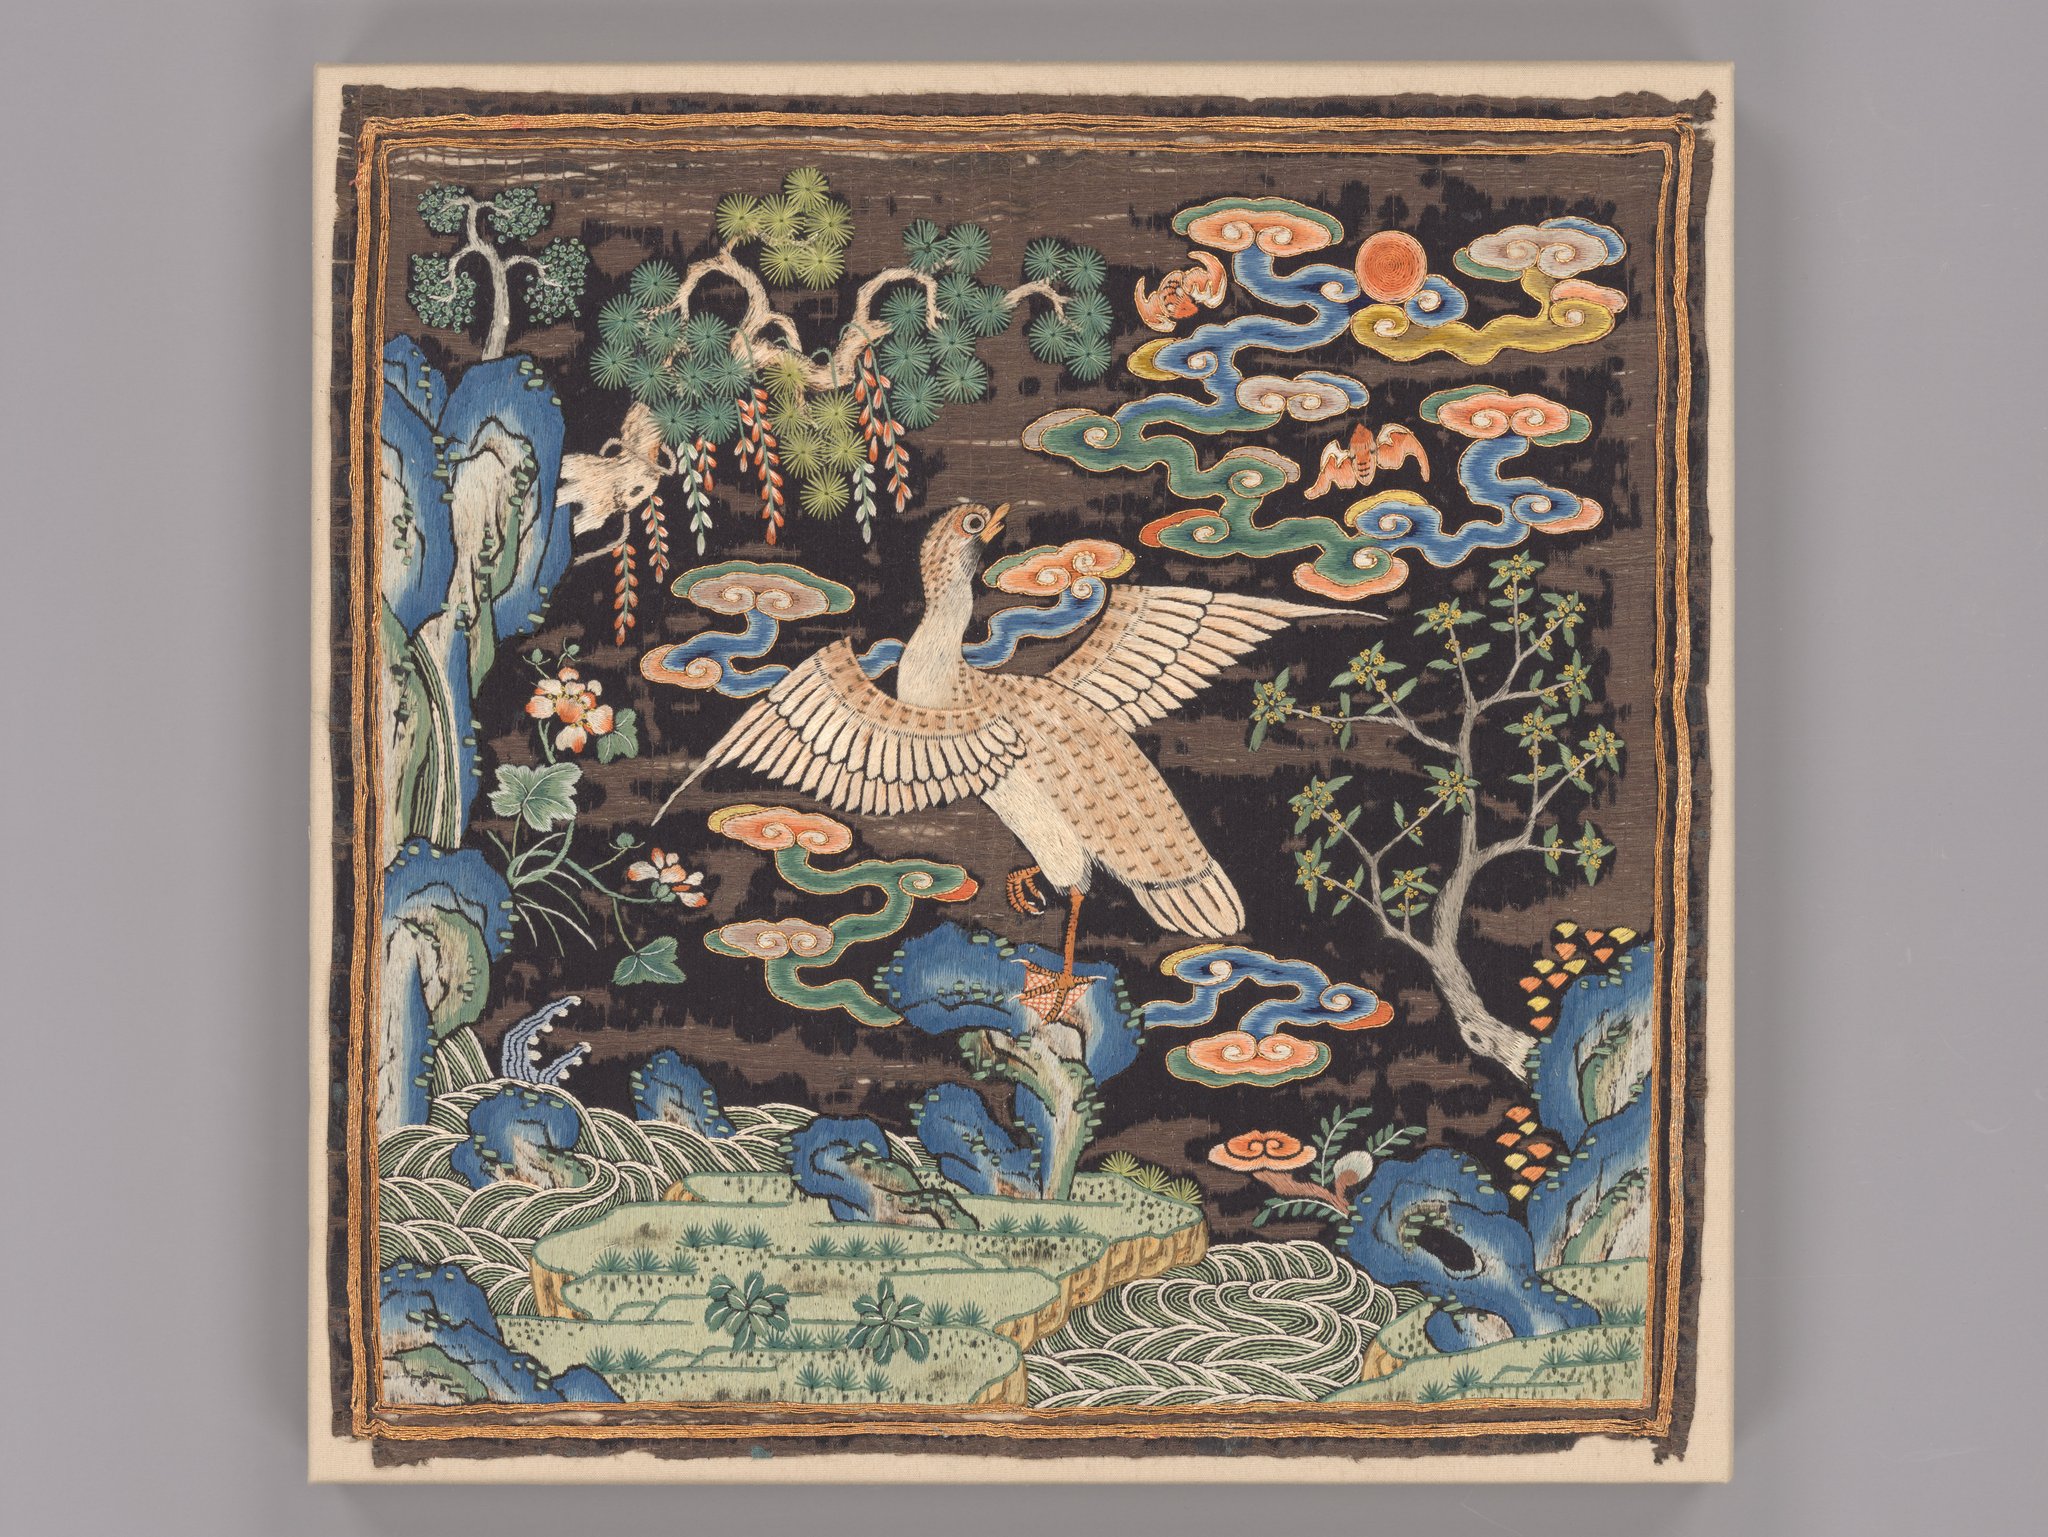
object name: rank badge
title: Rank Badge with Wild Goose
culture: chinese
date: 1701-1800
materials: metal thread, silk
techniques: embroidery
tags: geese